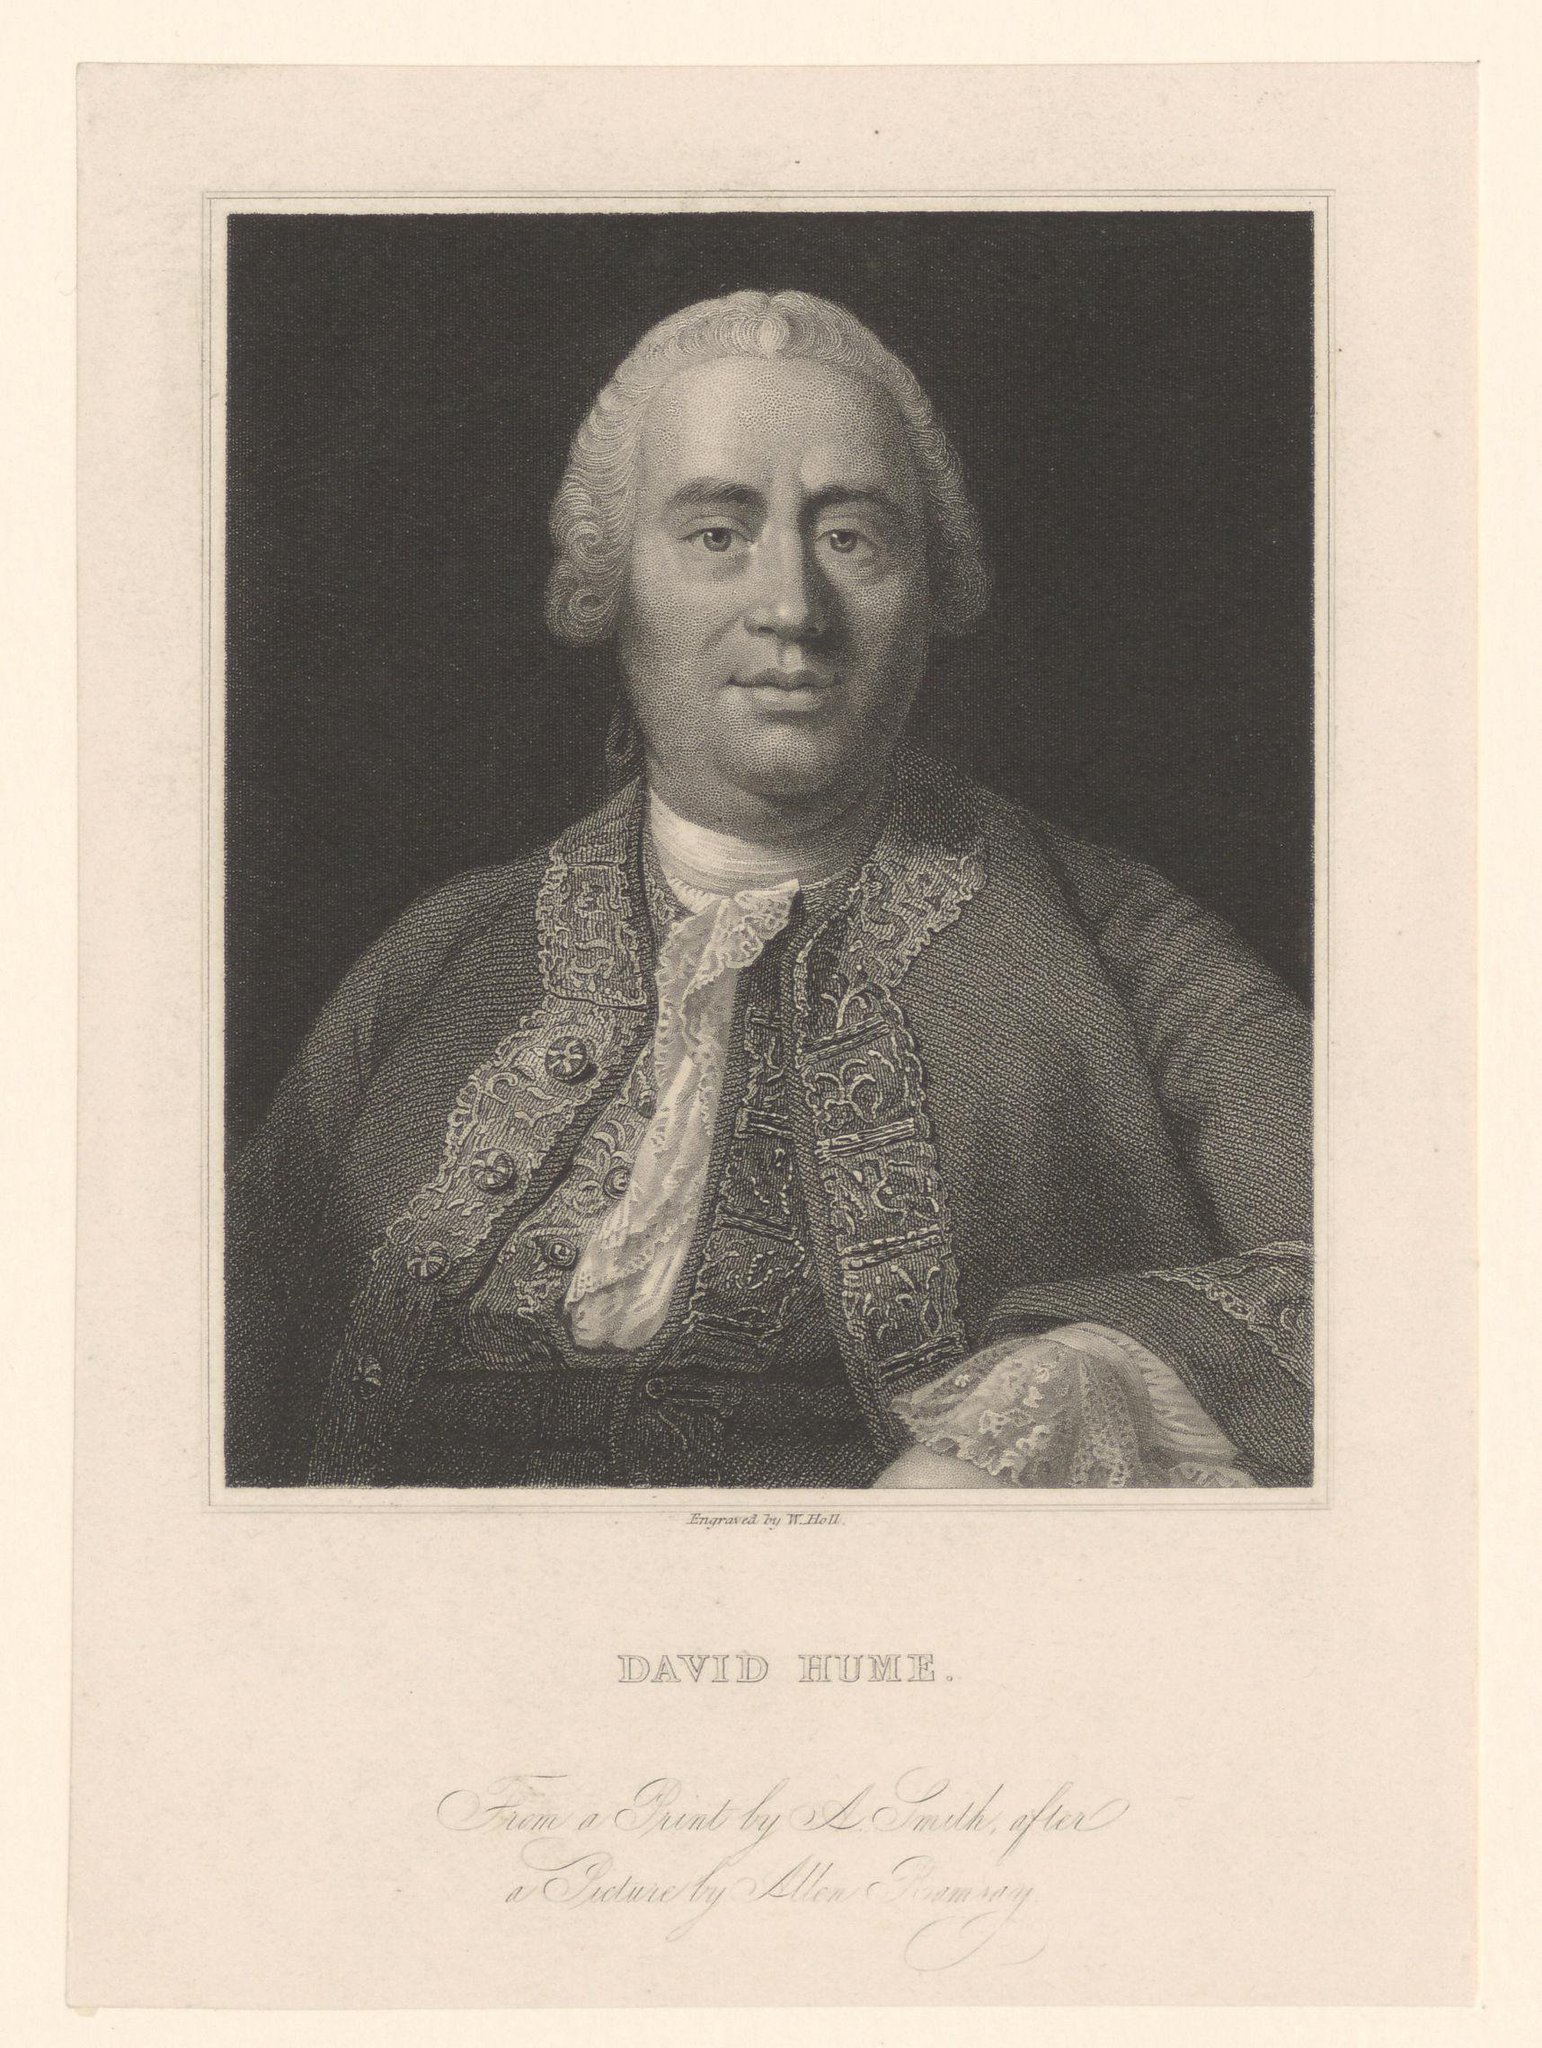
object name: print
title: David Hume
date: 1837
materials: paper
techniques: etching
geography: england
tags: david hume, historical persons, scholar, philosopher (+ portrait of scholar, scientist)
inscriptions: collector's mark: Lugt 2228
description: Prent uit: The Gallery of Portraits: With Memoirs. Londen: Charles Knight & Co., 1837, dl. 7.